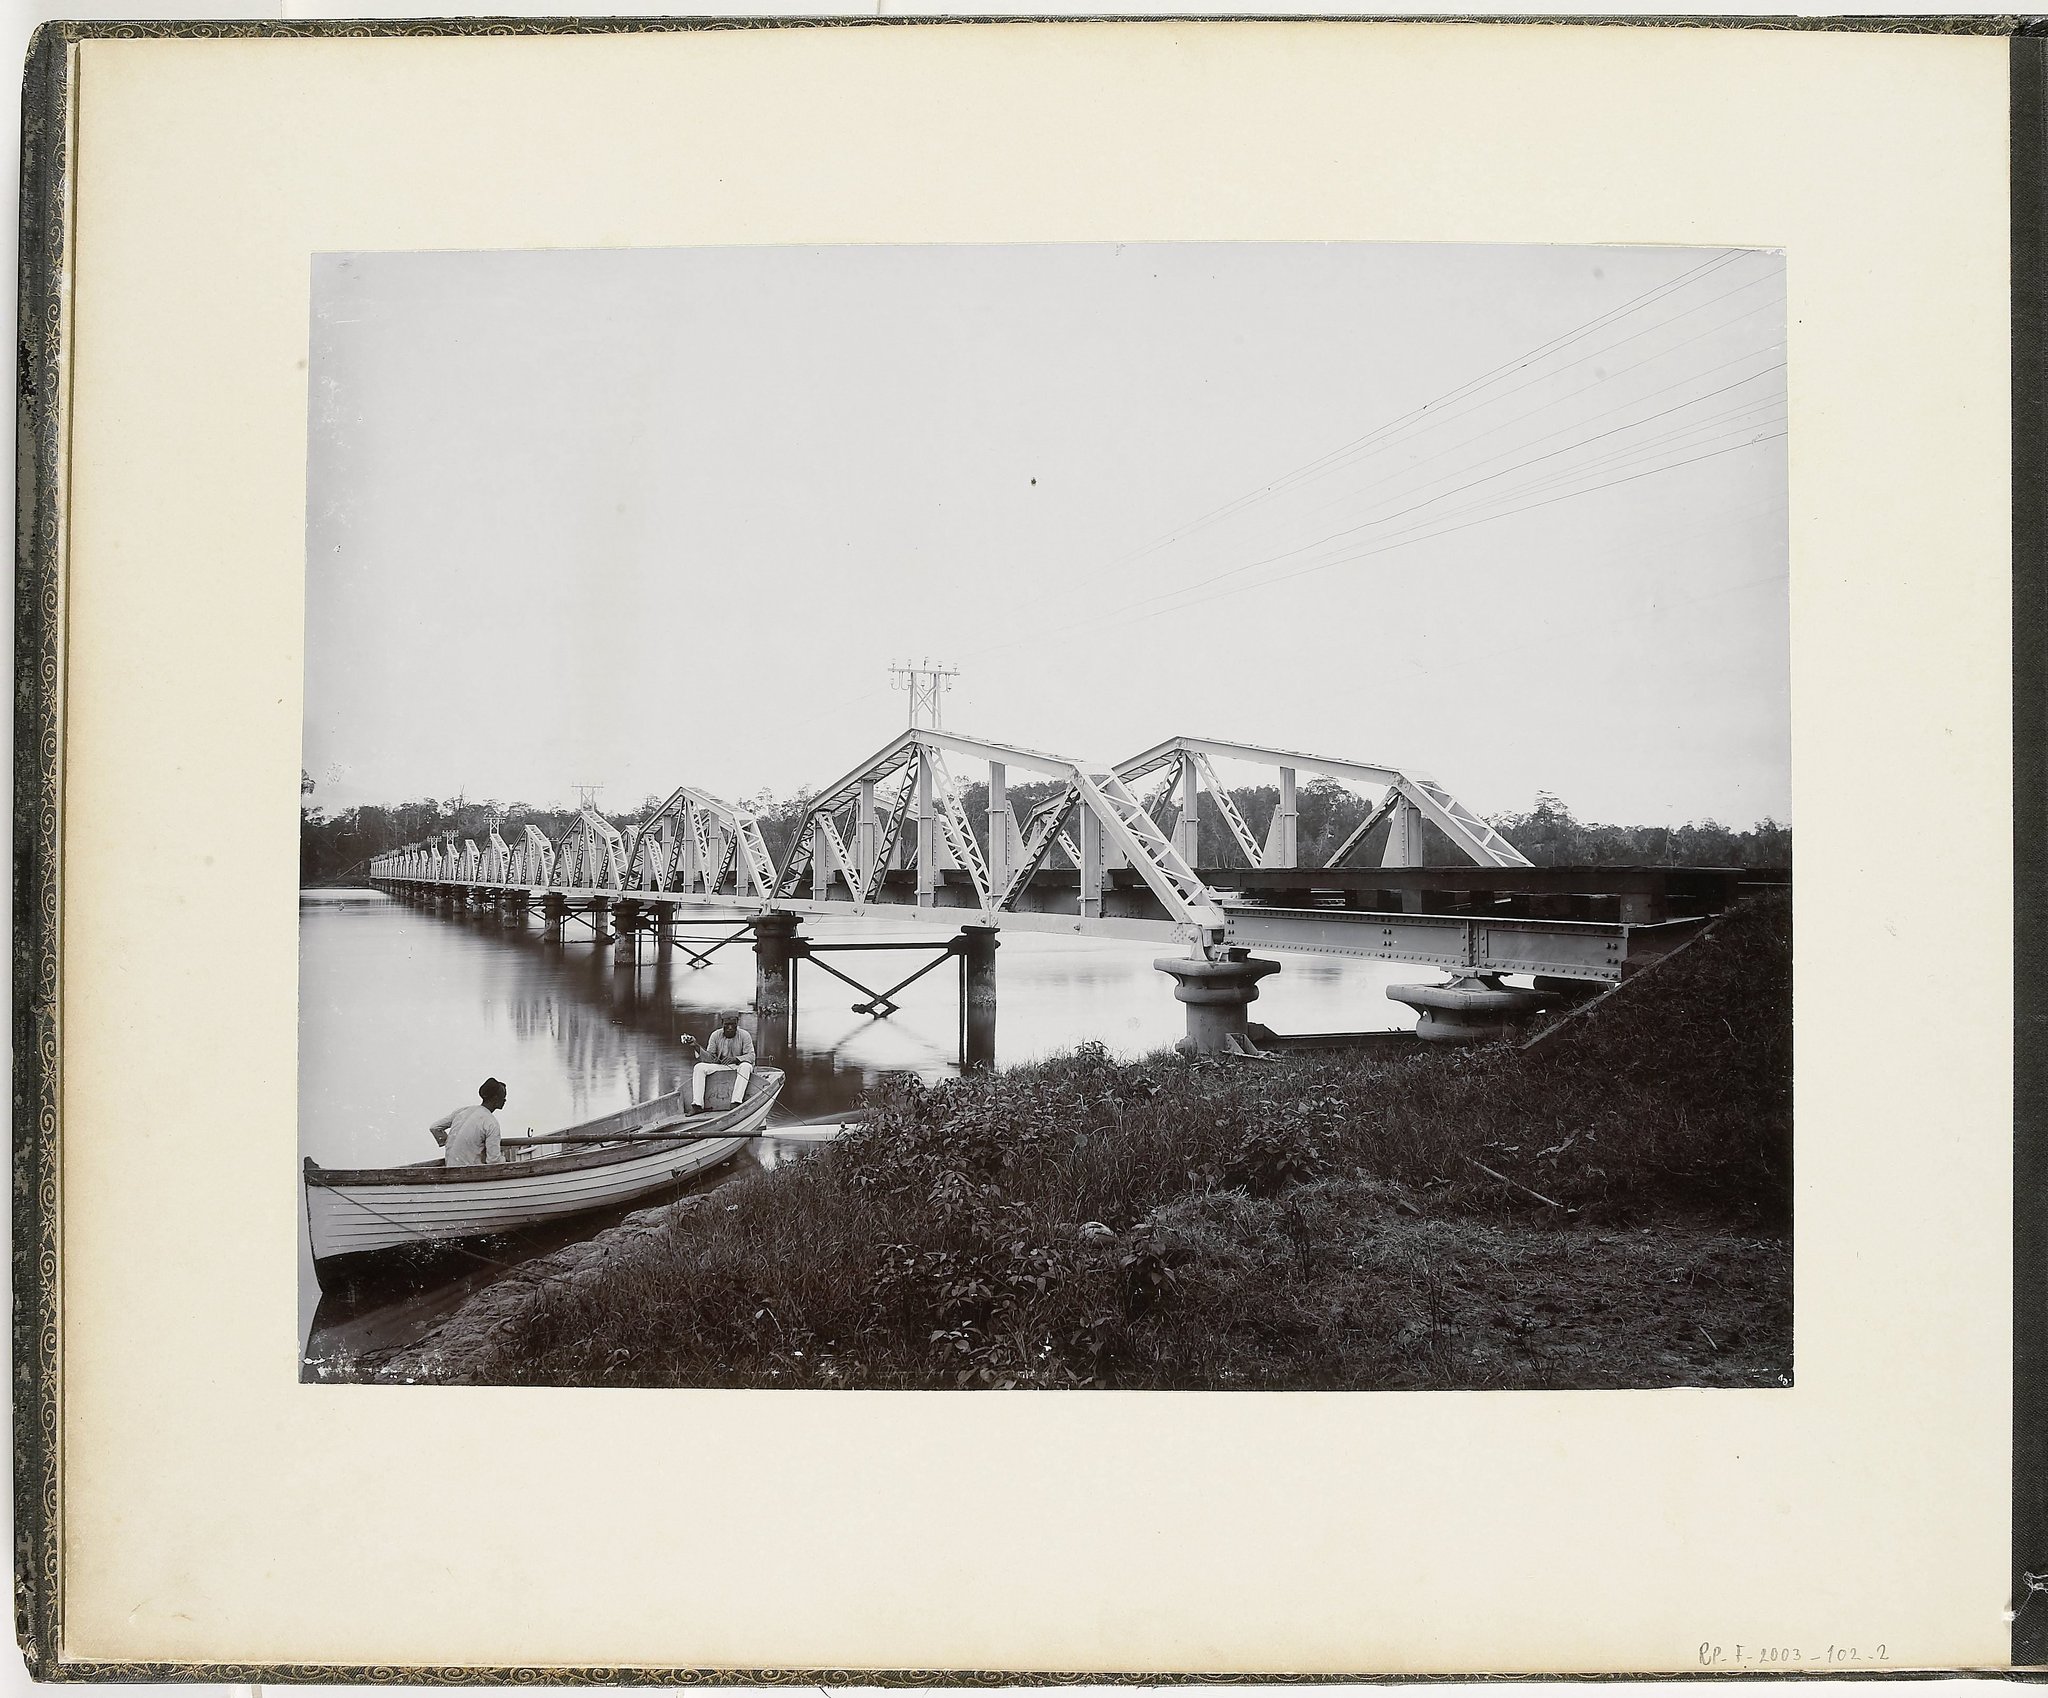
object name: photograph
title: Spoorbrug in Belawan, Sumatra (Eisenbahnbrücke in S. Belawan)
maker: carl j. kleingrothe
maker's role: fotograaf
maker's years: 1864-1925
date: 1885-1900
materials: photographic support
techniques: collodion silver print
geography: medan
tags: sumatra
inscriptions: negative number: ‘3.’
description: Gezicht op de spoorbrug van de Deli Spoorweg Maatschappij (DSM) over de Belawan rivier, bij de oever op de voorgrond twee mannen in een roeibootje. Onderdeel van het Sumatra fotoalbum van Paul en Lucie Sandel uit 1900.